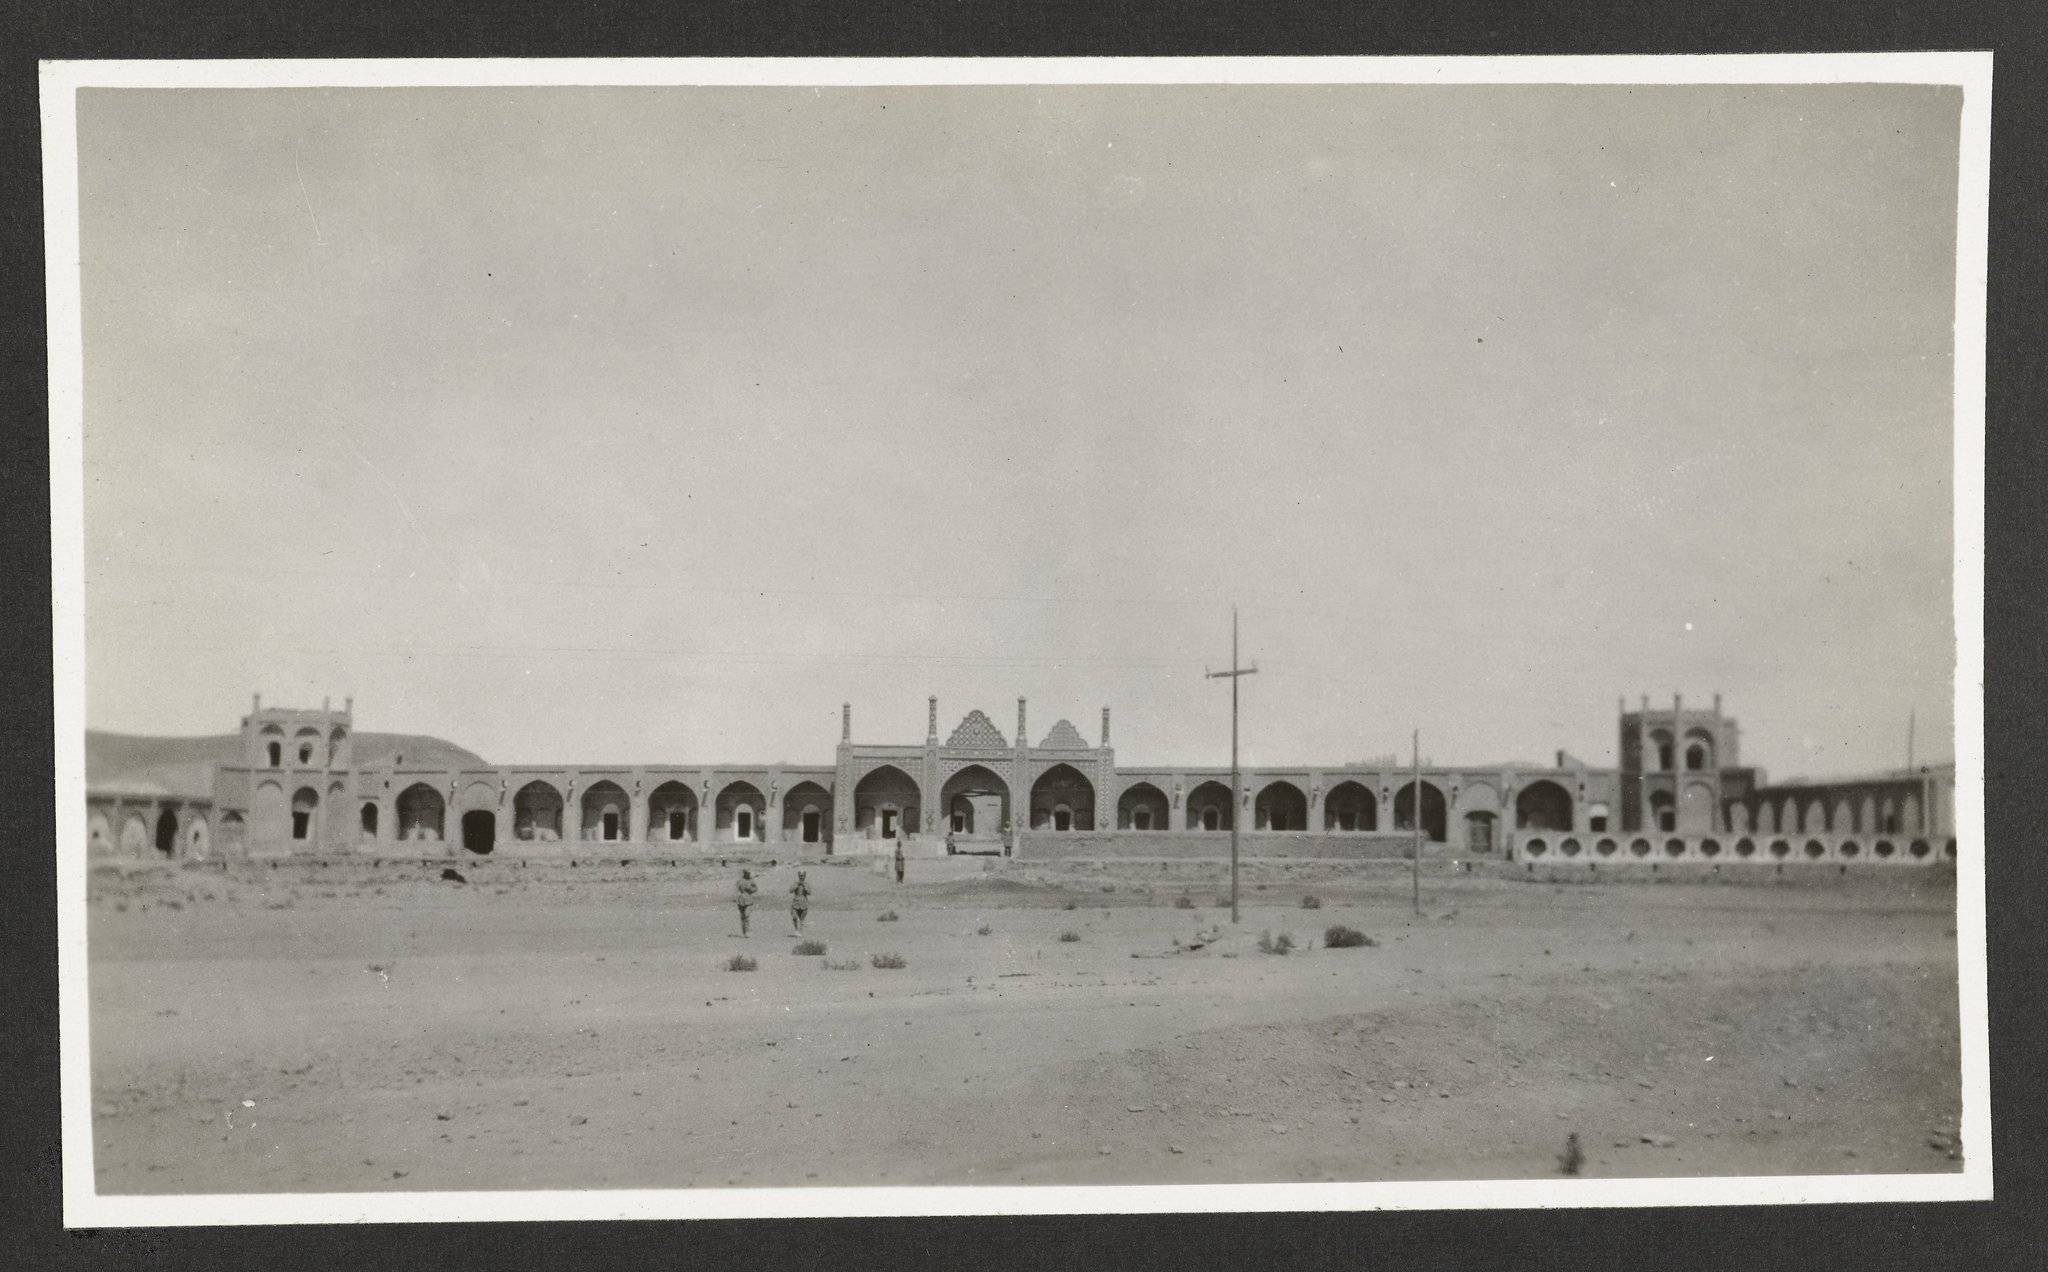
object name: photograph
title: Karavanserai tussen Derjaan en Teheran, Perzië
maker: a.g.a. van eelde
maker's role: engineer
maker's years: 1862-1950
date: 1925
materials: cardboard, paper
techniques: gelatin silver print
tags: iran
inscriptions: number: ‘29.’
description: Titel op object afkomstig uit inventaris (Verklaring der Photo's) behorend bij het album.